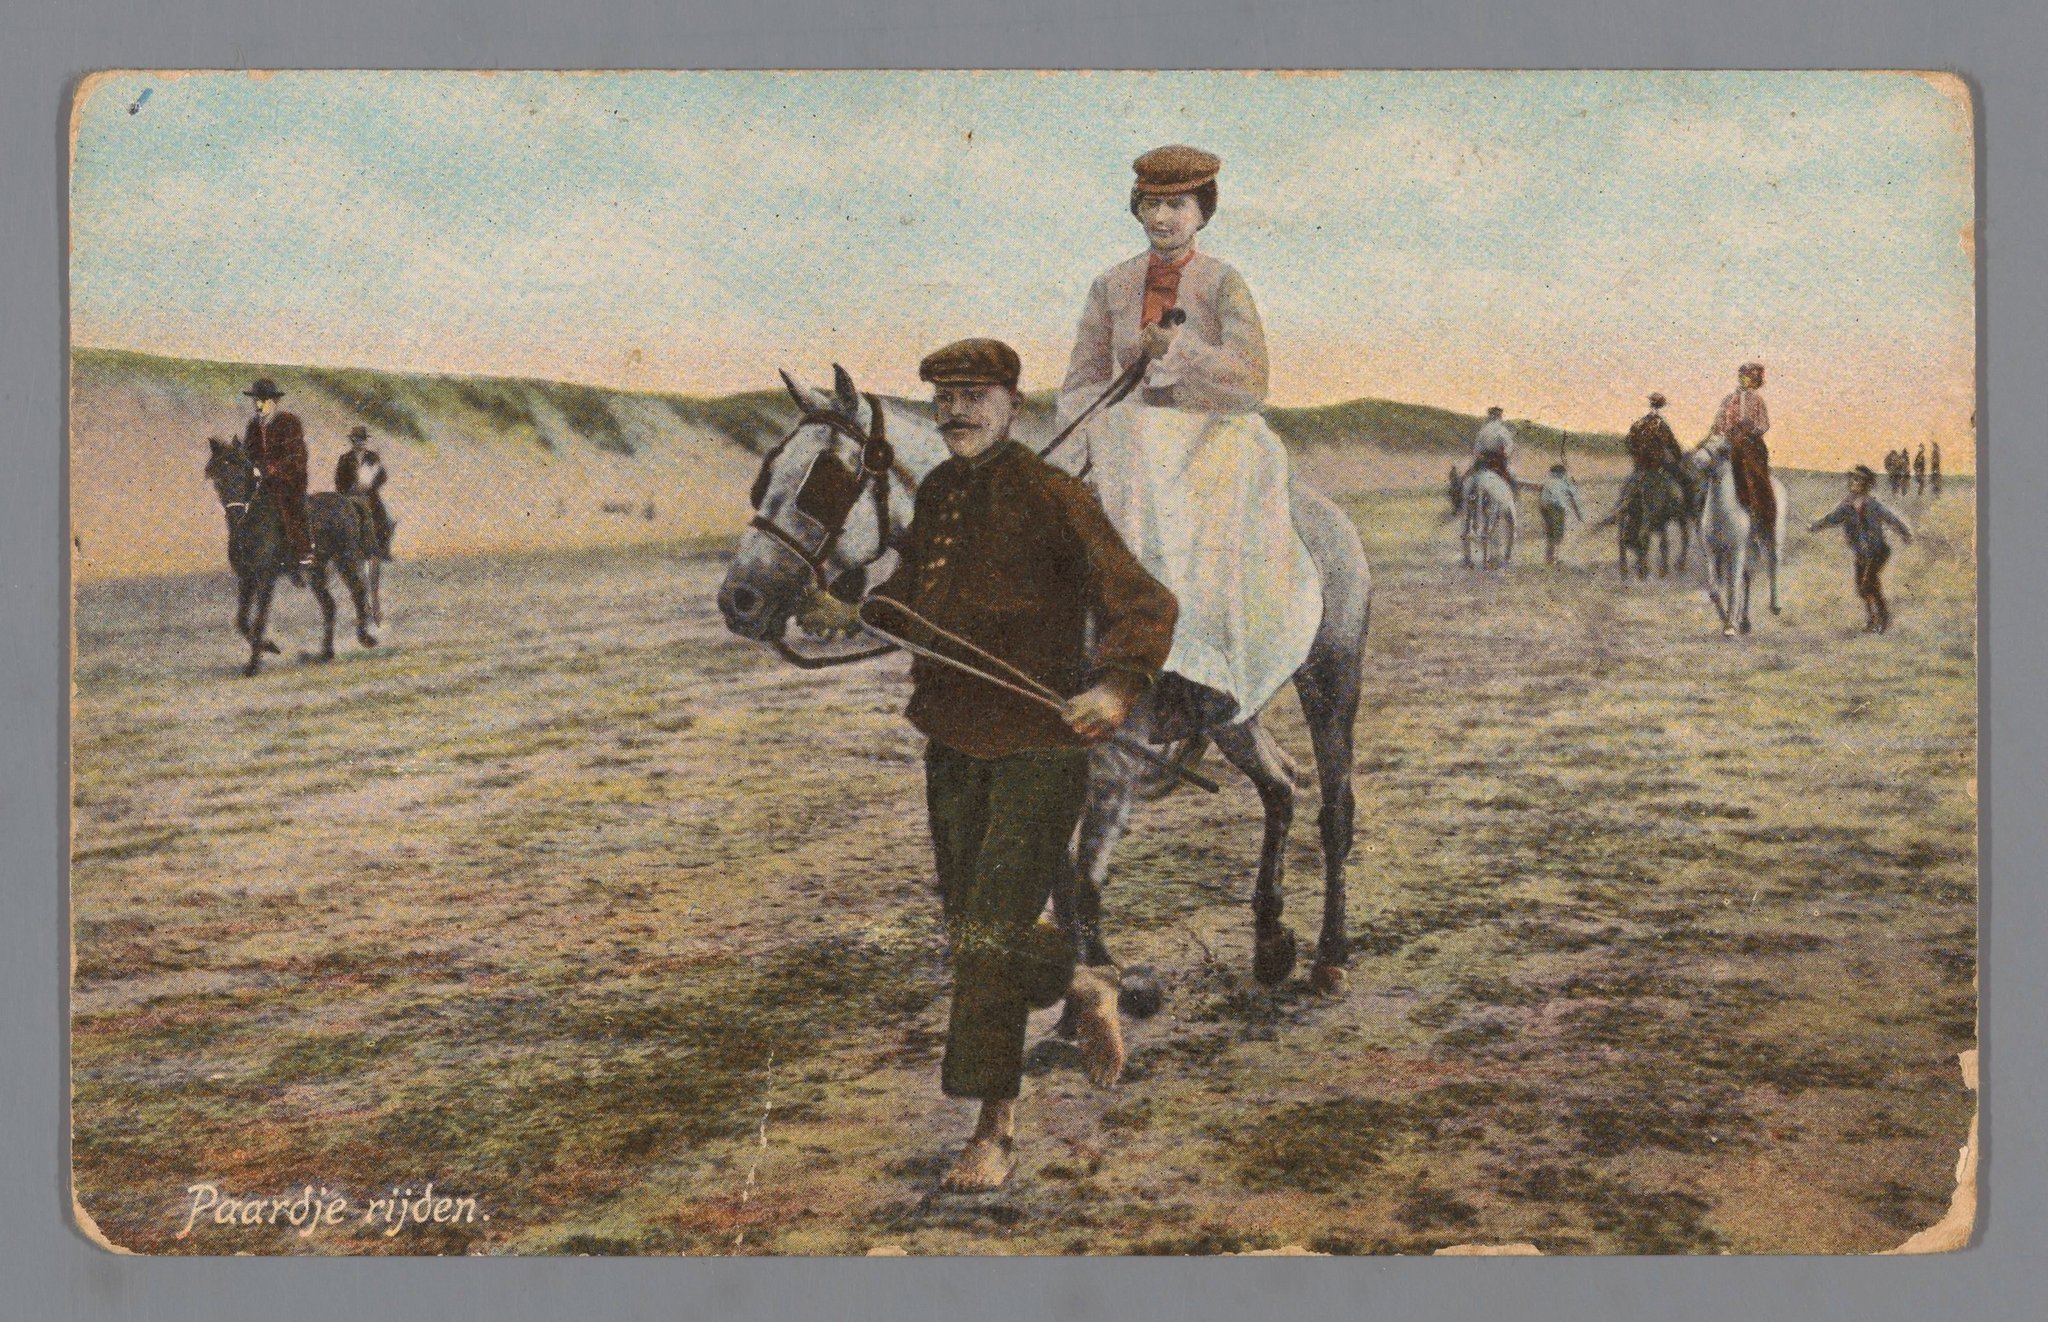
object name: photomechanical print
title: Paardje rijden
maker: Anonymous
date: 1908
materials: cardboard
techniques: writing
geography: leipzig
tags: riding a horse, ass, or mule; rider, horseman, beach